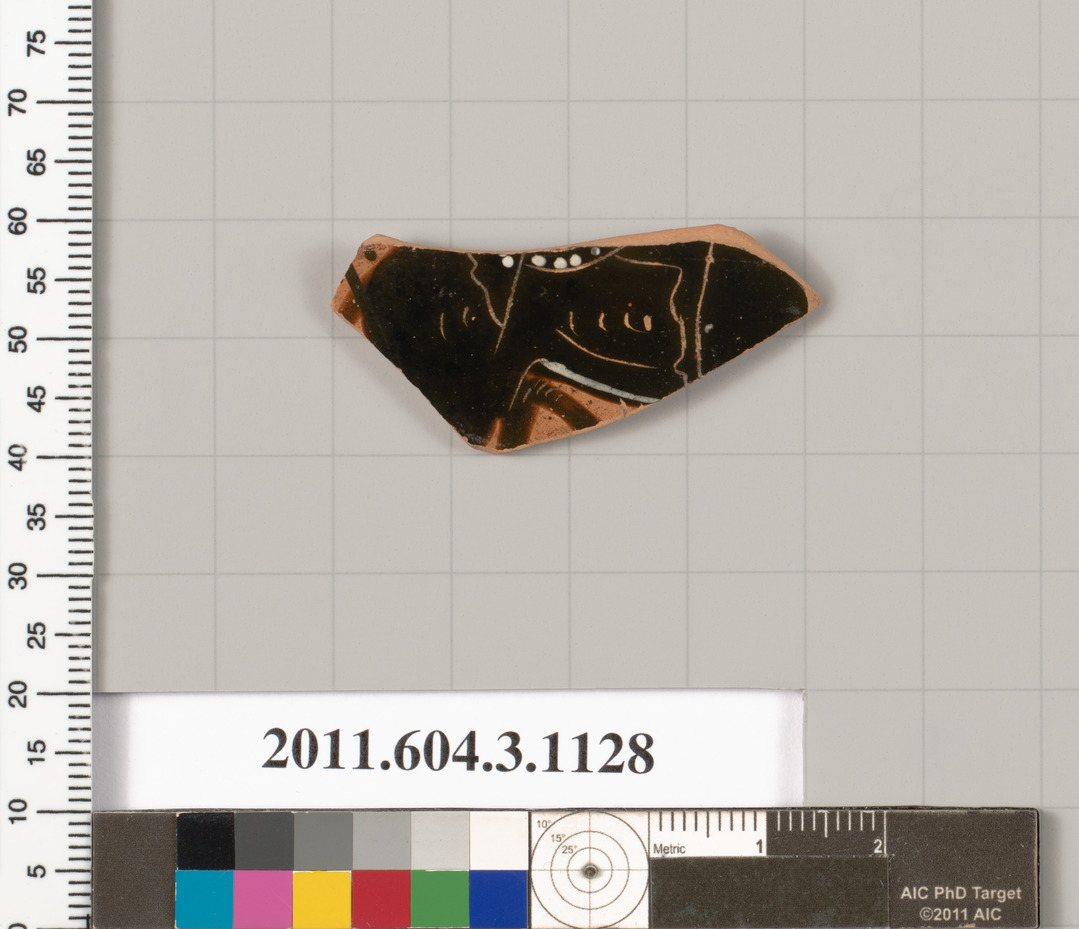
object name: mastoid or kyathos fragment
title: Terracotta fragment of a mastoid (drinking cup with narrow base) or a kyathos (cup-shaped ladle)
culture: greek, attic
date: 534-468 BCE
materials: terracotta